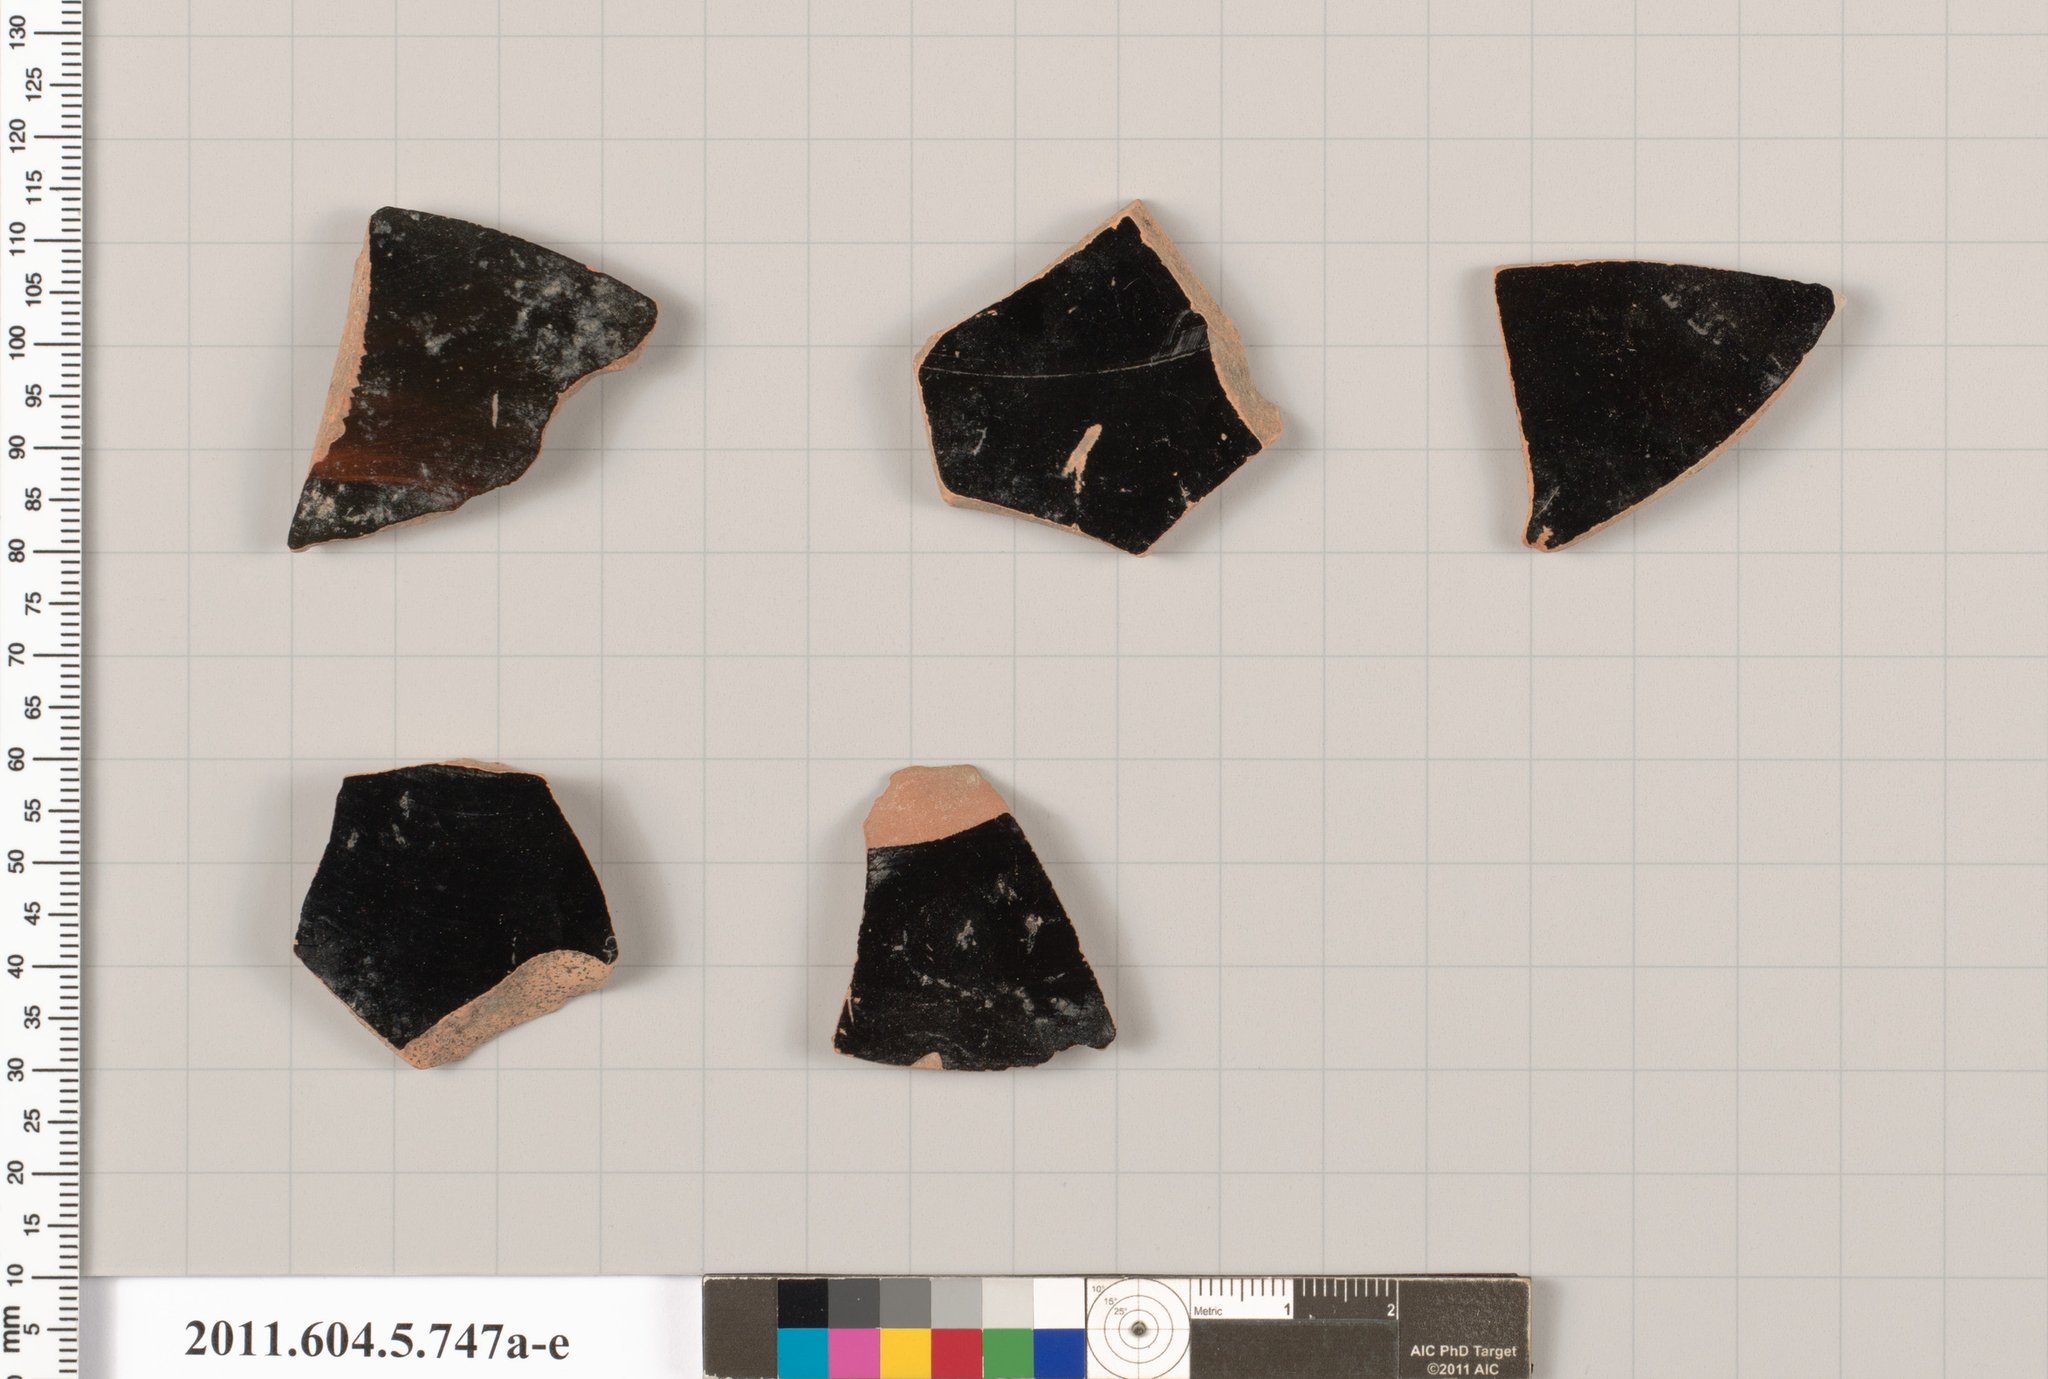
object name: kylix fragment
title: Terracotta fragments of kylikes (drinking cups)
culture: greek, attic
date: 600-401 BCE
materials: terracotta